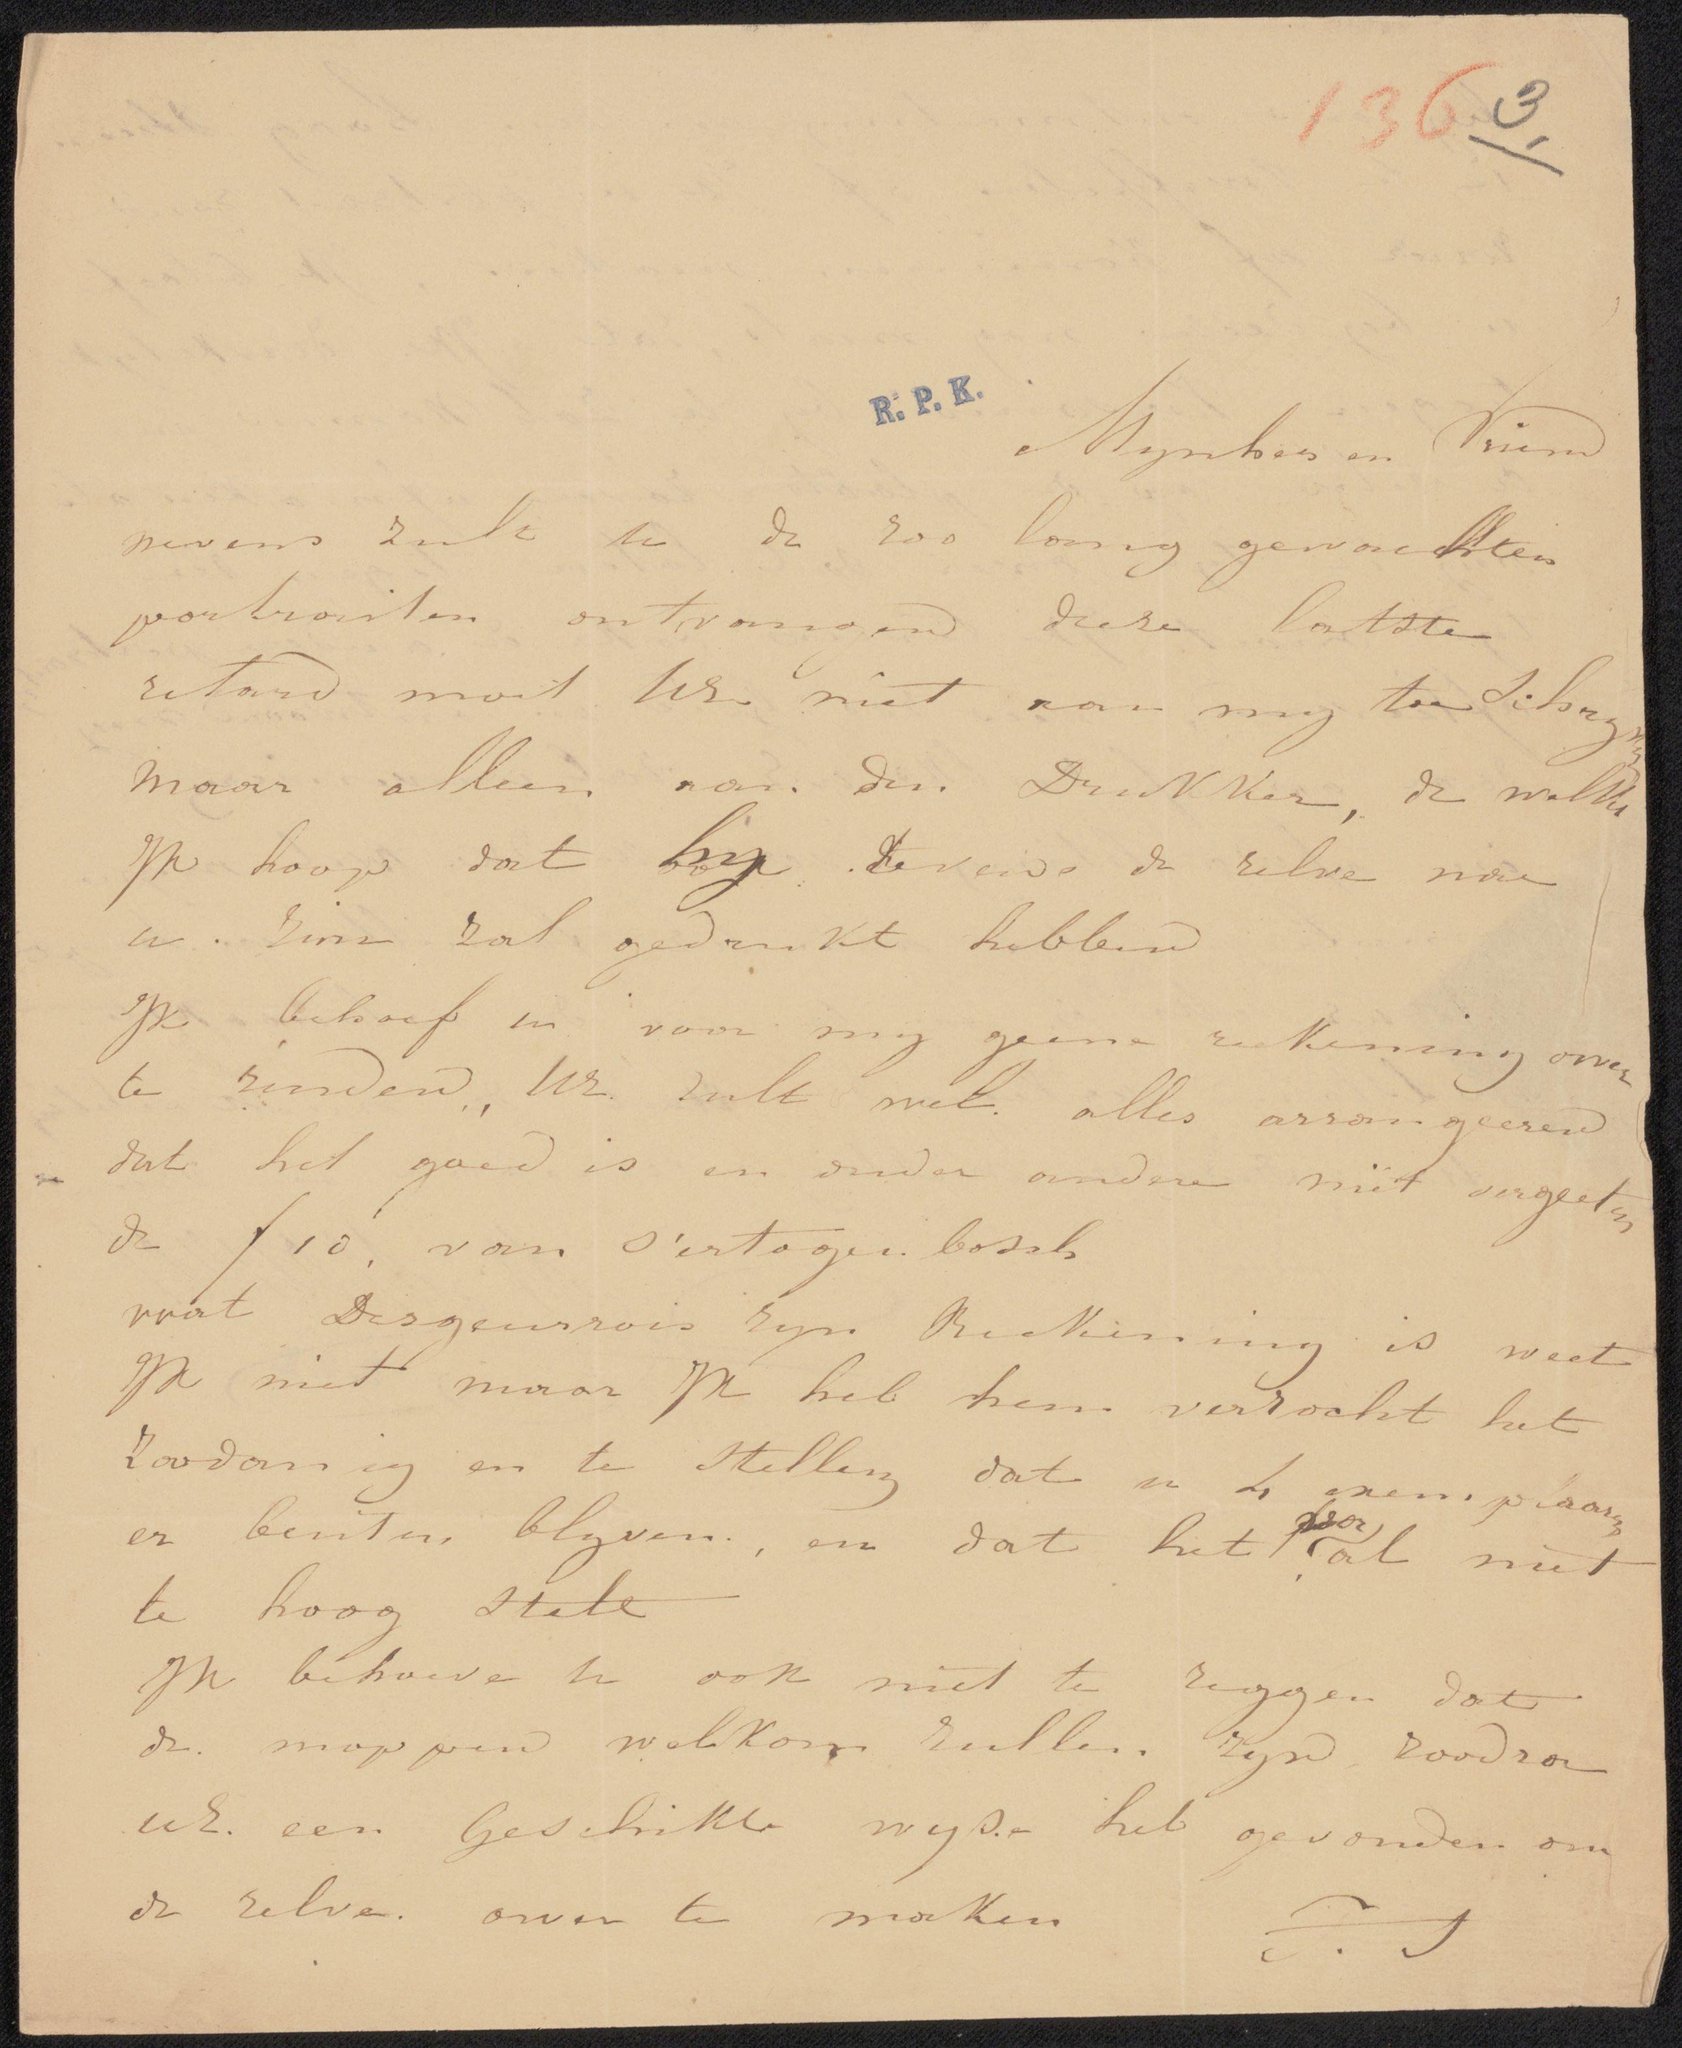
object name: letter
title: Brief aan Christiaan Kramm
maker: michel mourot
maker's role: draughtsman, print maker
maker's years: 1803-1847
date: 1813-1847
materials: ink, paper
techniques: pen, writing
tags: christiaan kramm, the graphic arts, anonymous historical person portrayed, historical persons (portraits and scenes from the life), money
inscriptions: collector's mark: Lugt 2233, watermark